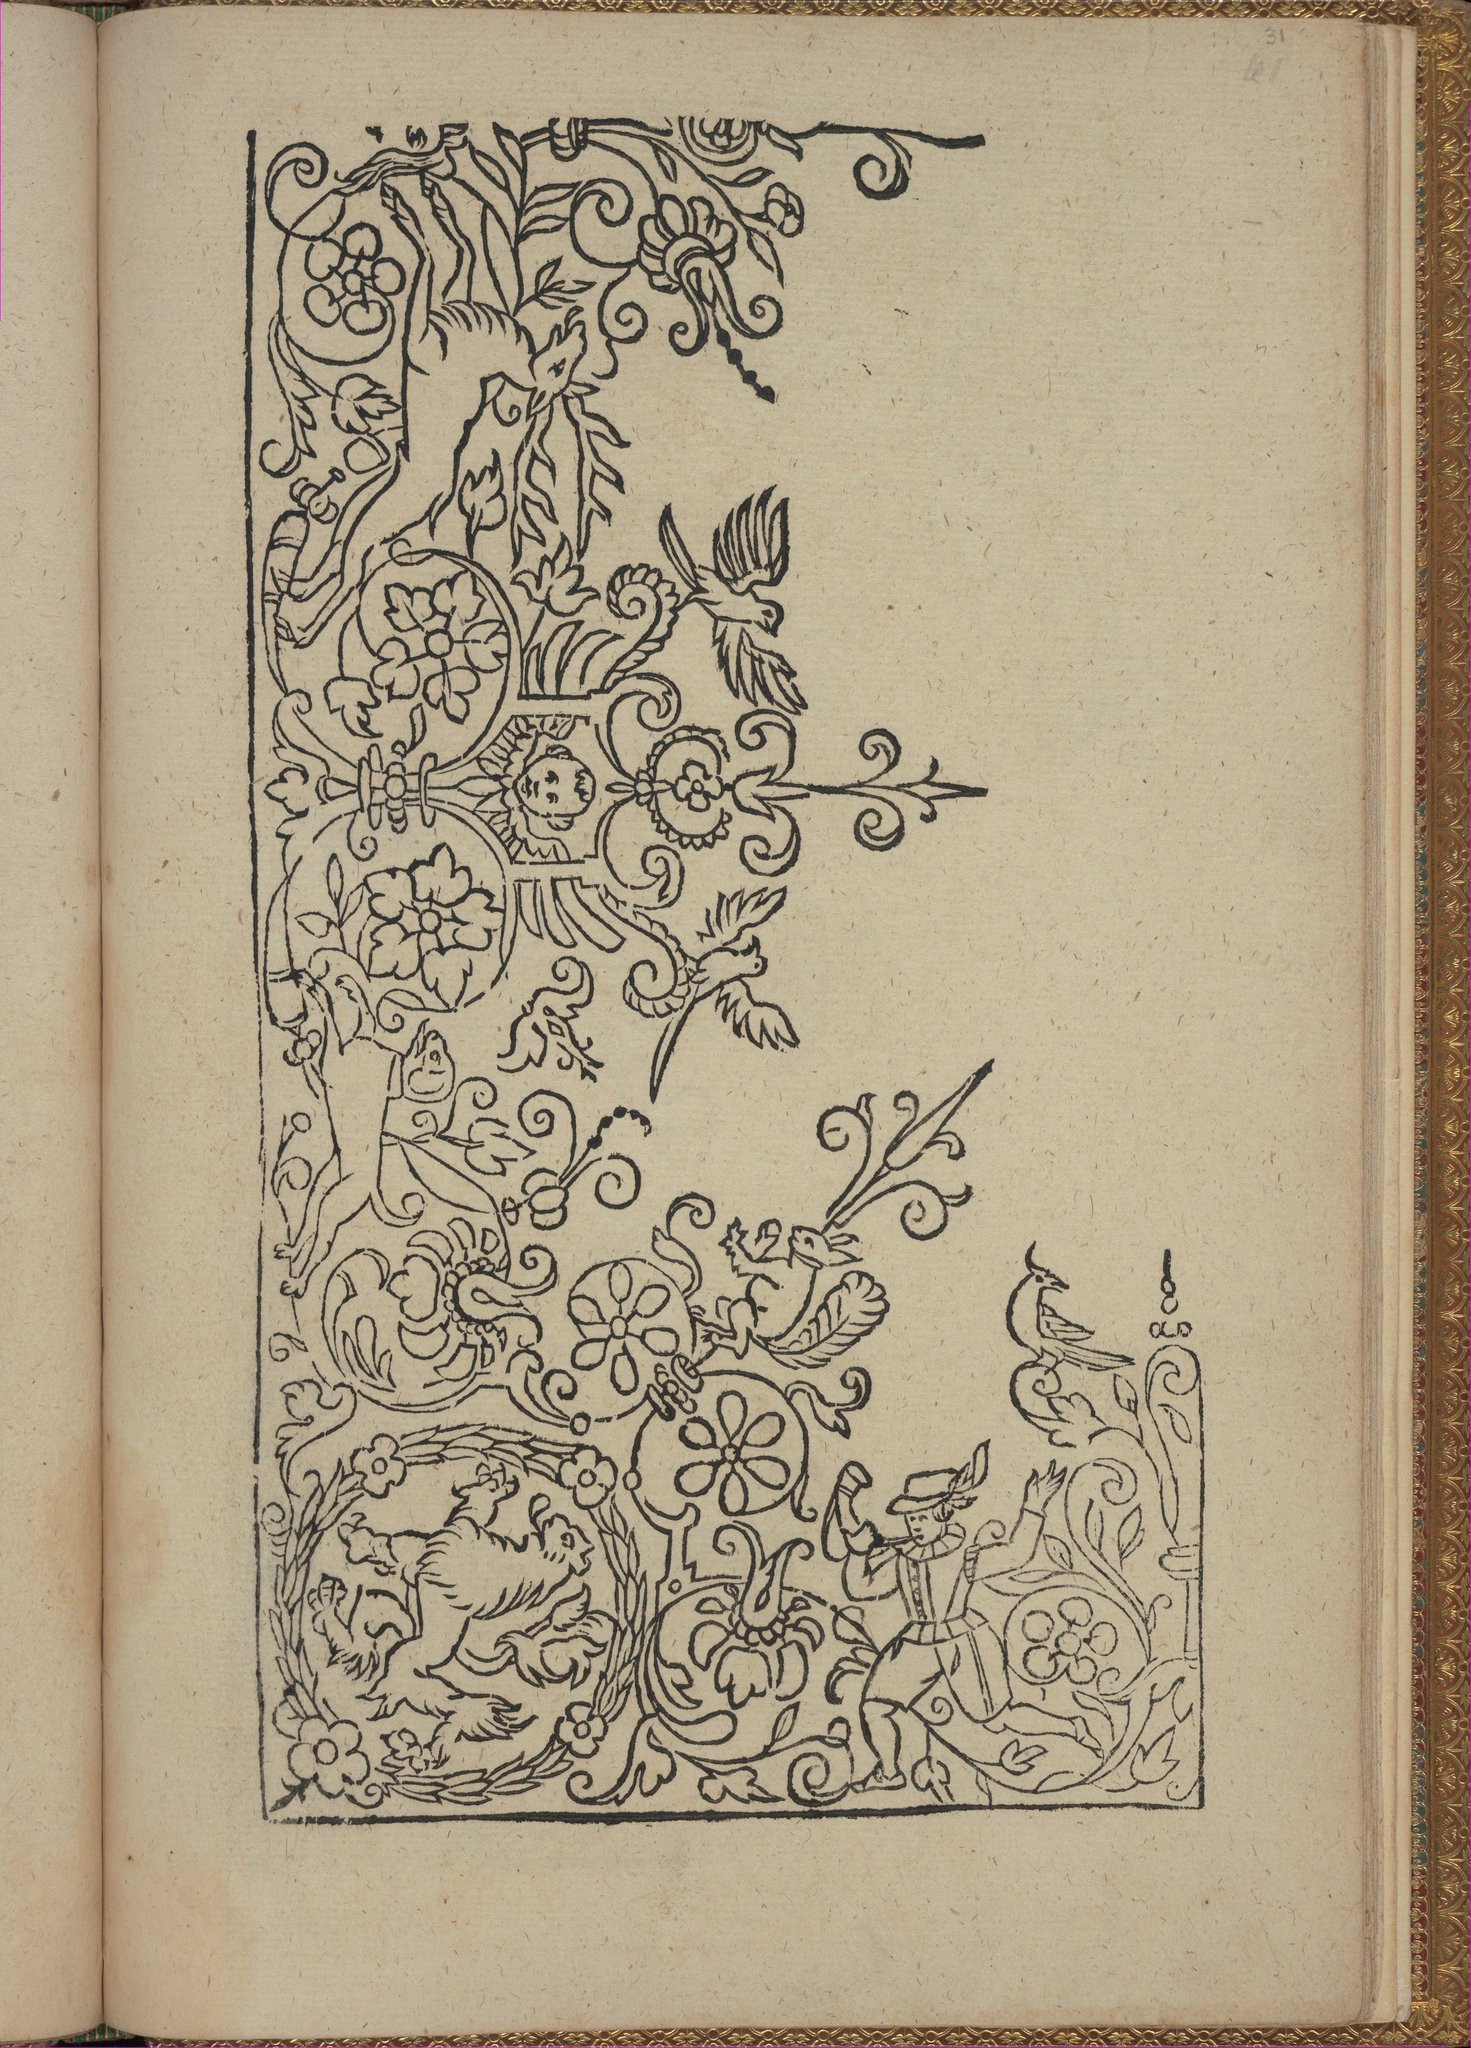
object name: book print ornament architecture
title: New Modelbüch (Page 31r)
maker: andreas bretschneider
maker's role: designer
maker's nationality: german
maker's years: 1573-1645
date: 1615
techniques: woodcut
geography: germany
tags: birds,flowers